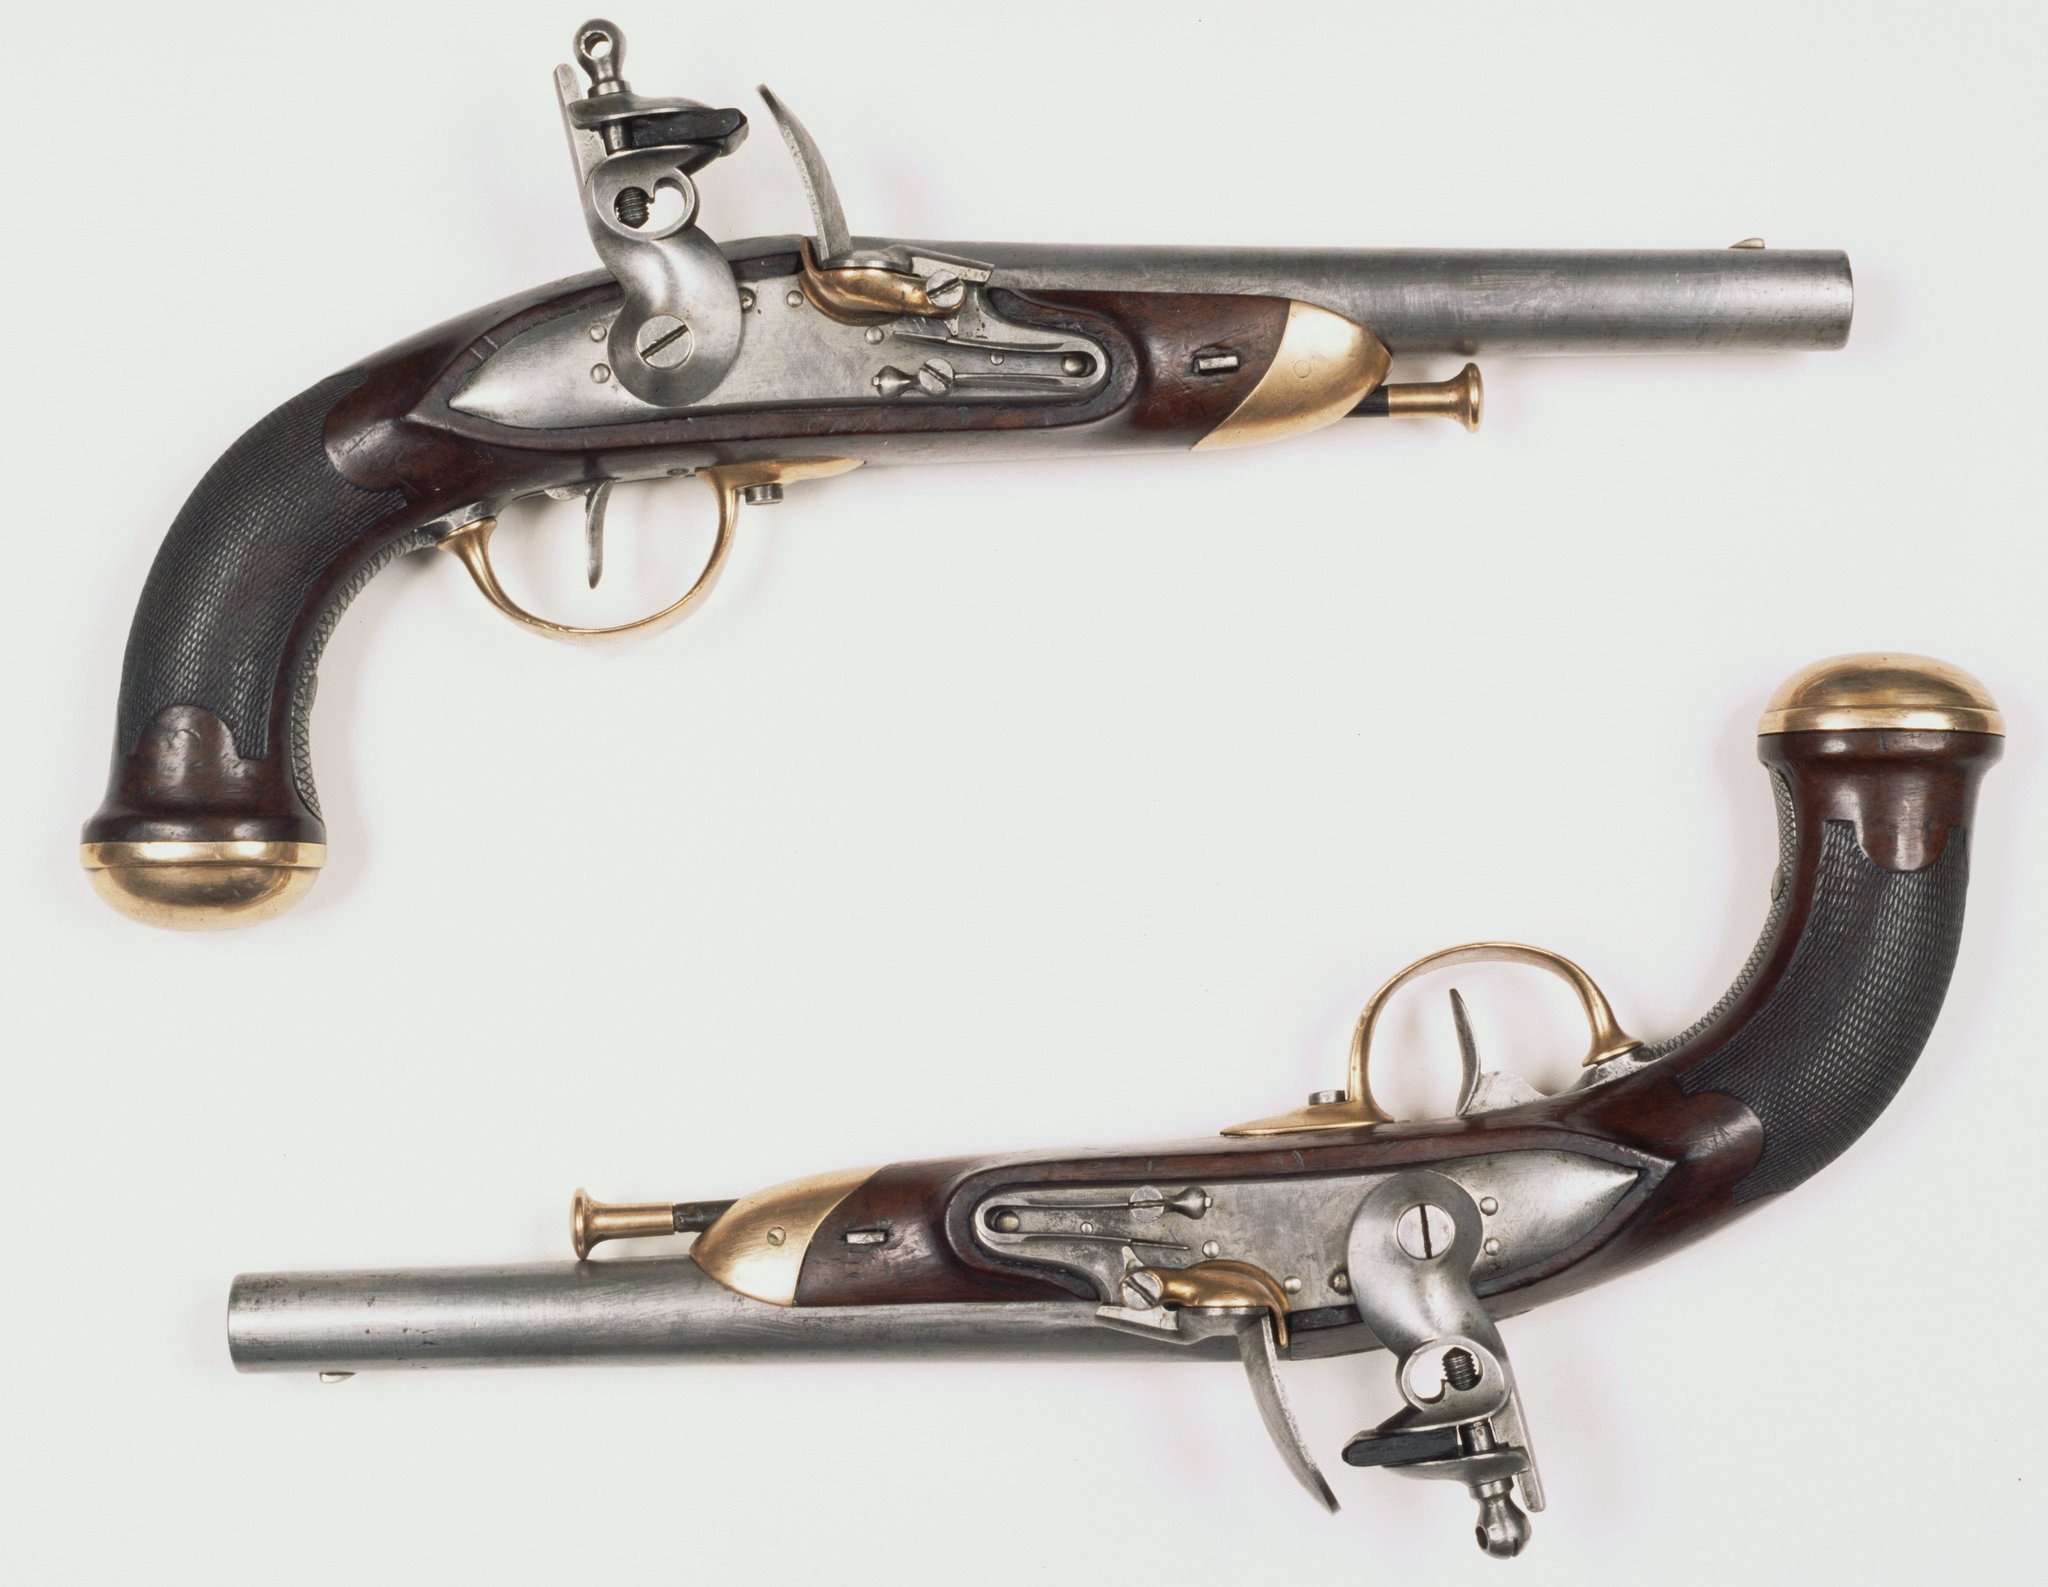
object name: flintlock pistol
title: Vuursteenpistool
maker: Anonymous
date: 1700-1800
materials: copper, alloy, iron, wood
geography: liège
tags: netherlands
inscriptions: mark: ‘E // L G // *’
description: Vuursteenpistool, deel van koppel, met gladde ronde loop met aan het uiteinde een kleine zilveren vizierkorrel, loop is gemerkt met 'ELG'. Houten lade met een koperen uiteinde, doorlopend in de kolf waarvan de greep geribbeld is en de kolfplaat van koper is. IJzeren slotplaat met koperen pan. Een houten laadstok met koperen kop bevindt zich in de lade. Koperen trekkerbeugel met ijzeren trekker.